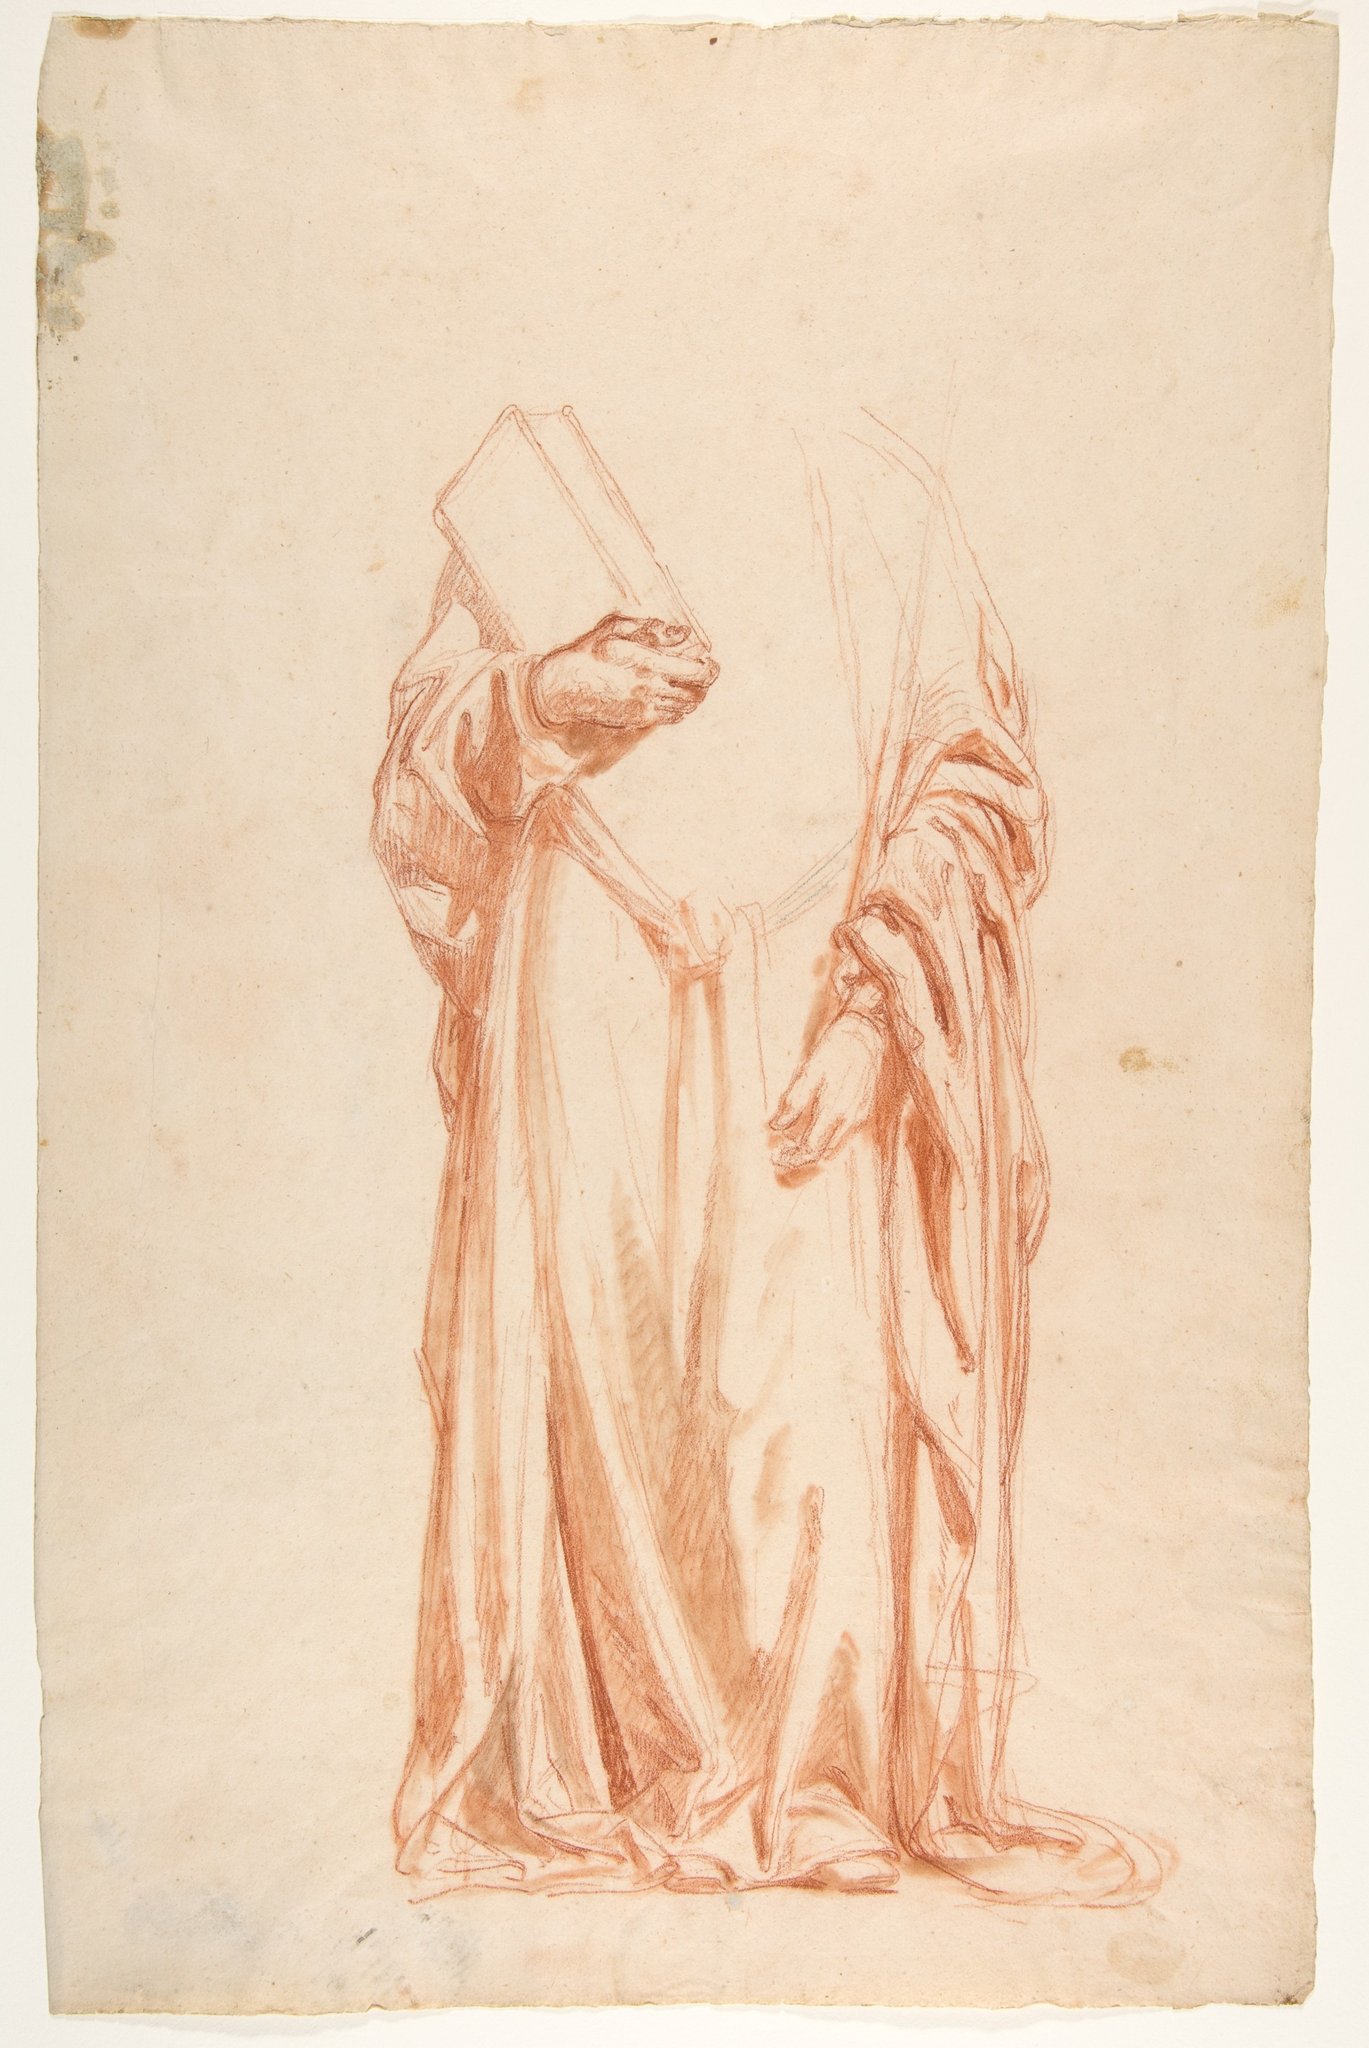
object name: drawing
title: Drapery Study for Sainte-Clotilde (upper register; study for wall paintings in the Chapel of Saint Remi, Sainte-Clotilde, Paris, 1858)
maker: isidore pils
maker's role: artist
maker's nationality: french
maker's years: 1813-1875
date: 1830-1875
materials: chalk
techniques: stumping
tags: books,saints